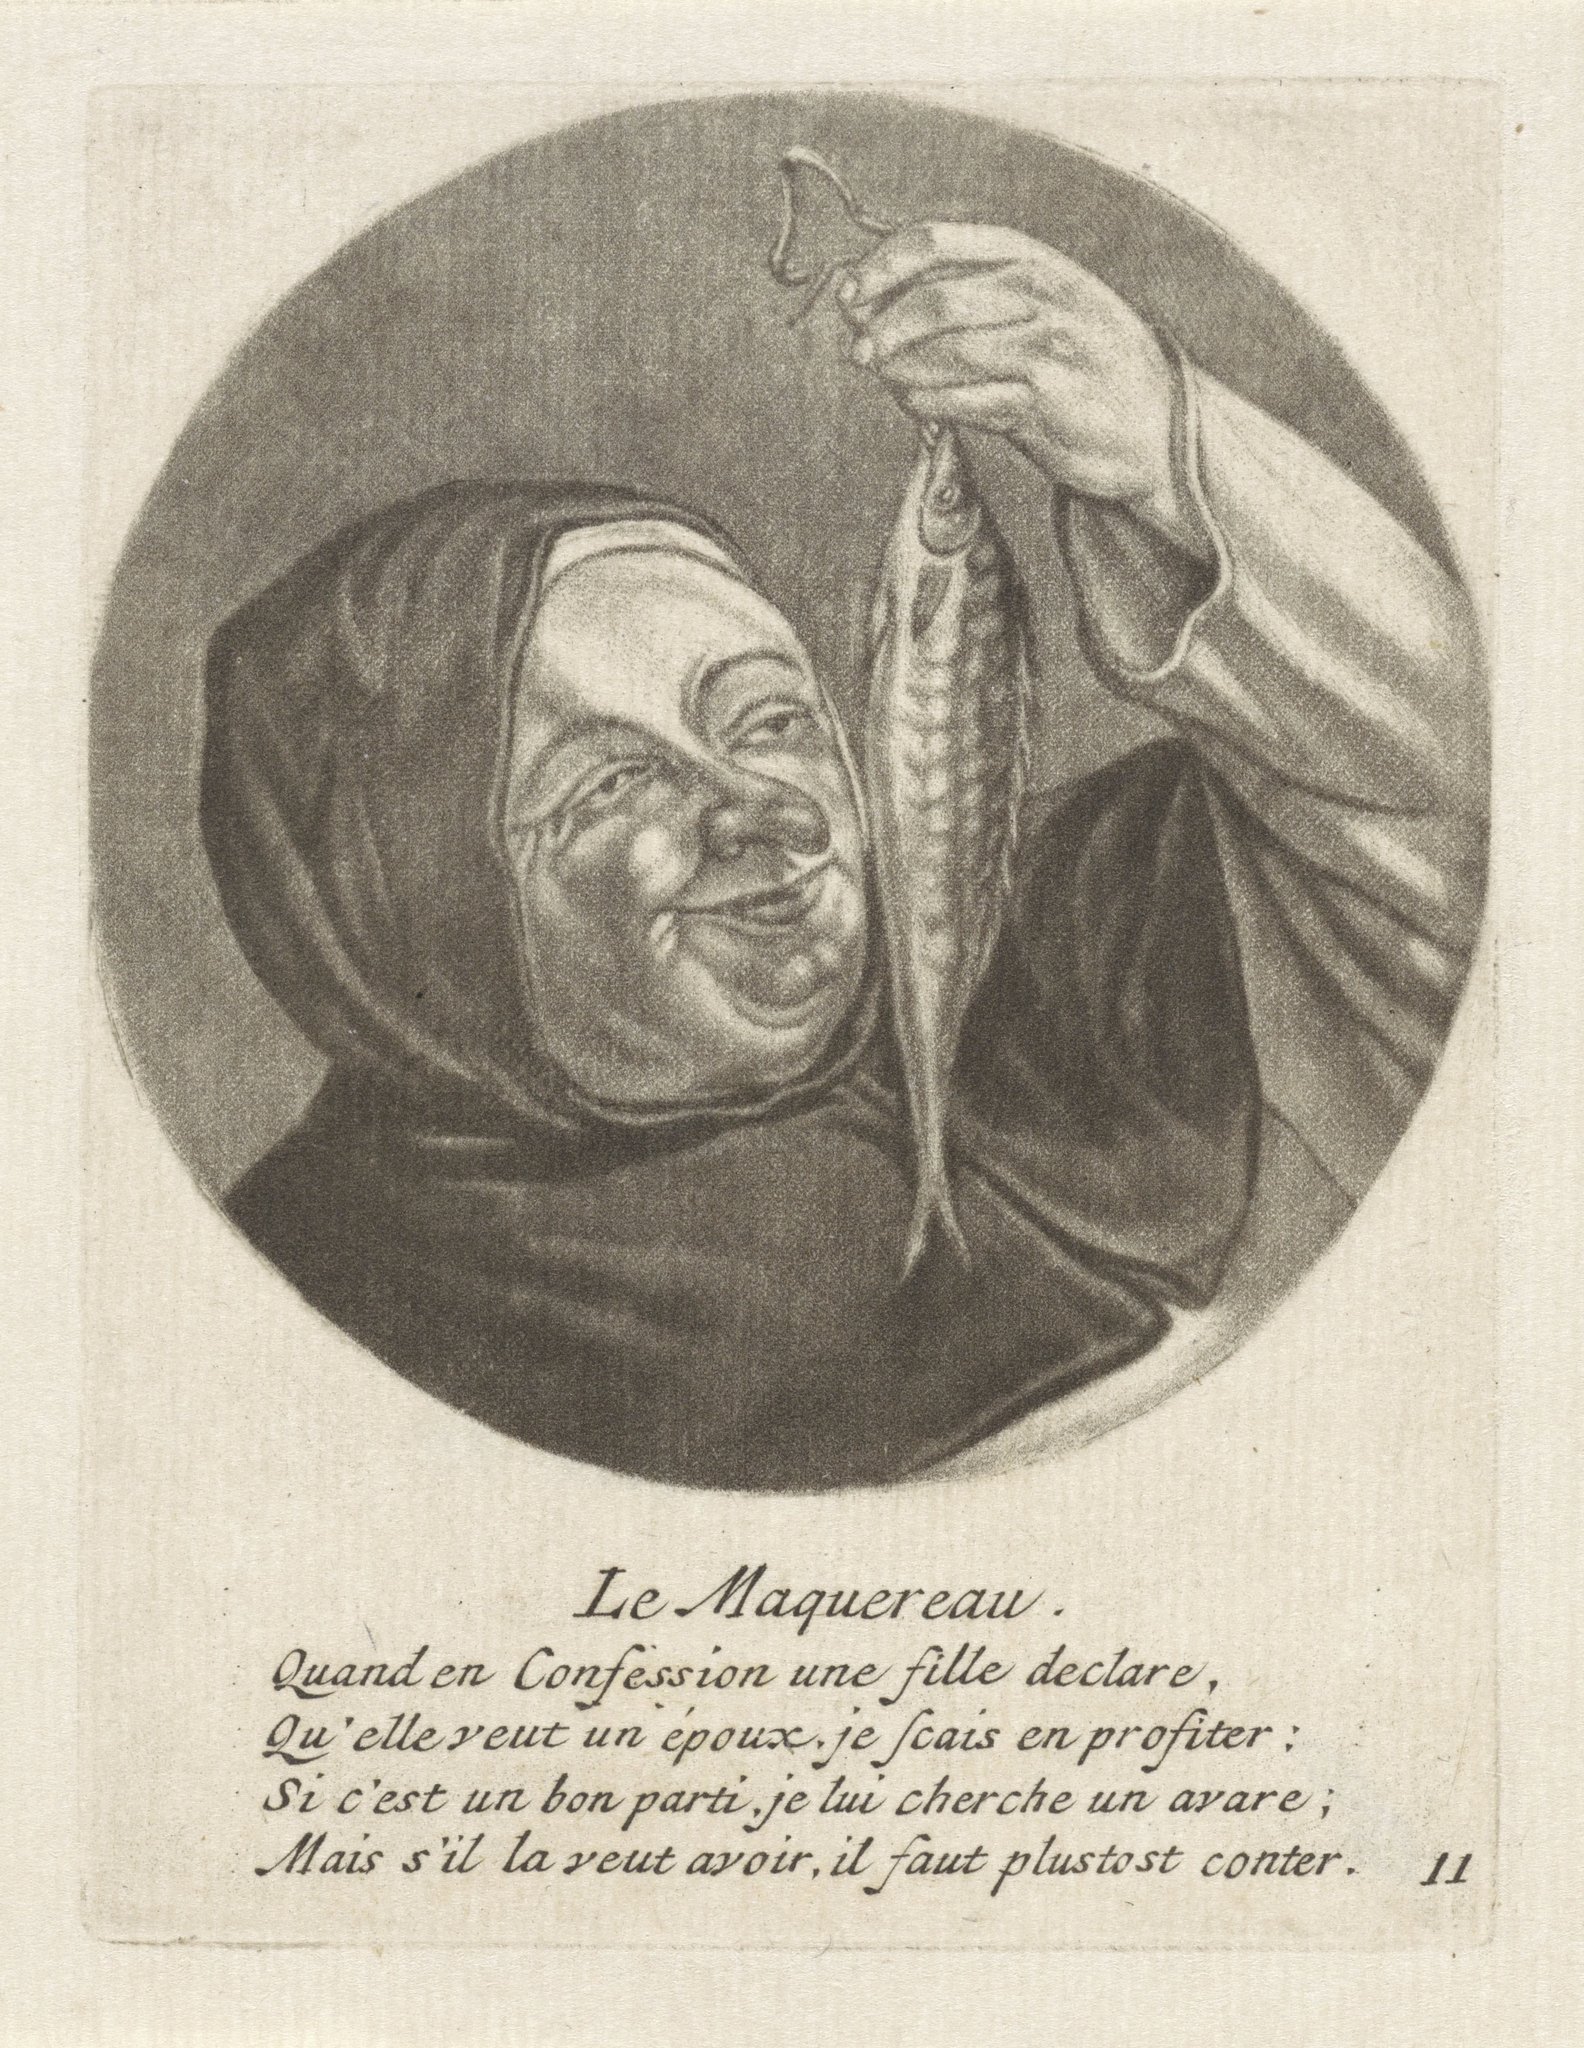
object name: print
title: Monnik met een makreel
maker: jacob gole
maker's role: print maker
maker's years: 1660-1724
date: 1670-1724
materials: paper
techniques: engraving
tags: monk(s), friar(s), bony fishes: mackerel, political caricatures and satires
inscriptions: collector's mark: Lugt 2228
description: De prent verscheen in de bundel "Renversement de la Morale Chrétienne par les désordres du Monachisme". Volgens Wiebke Schmoldt (1997) verscheen deze bundel tussen 1693 en 1700.